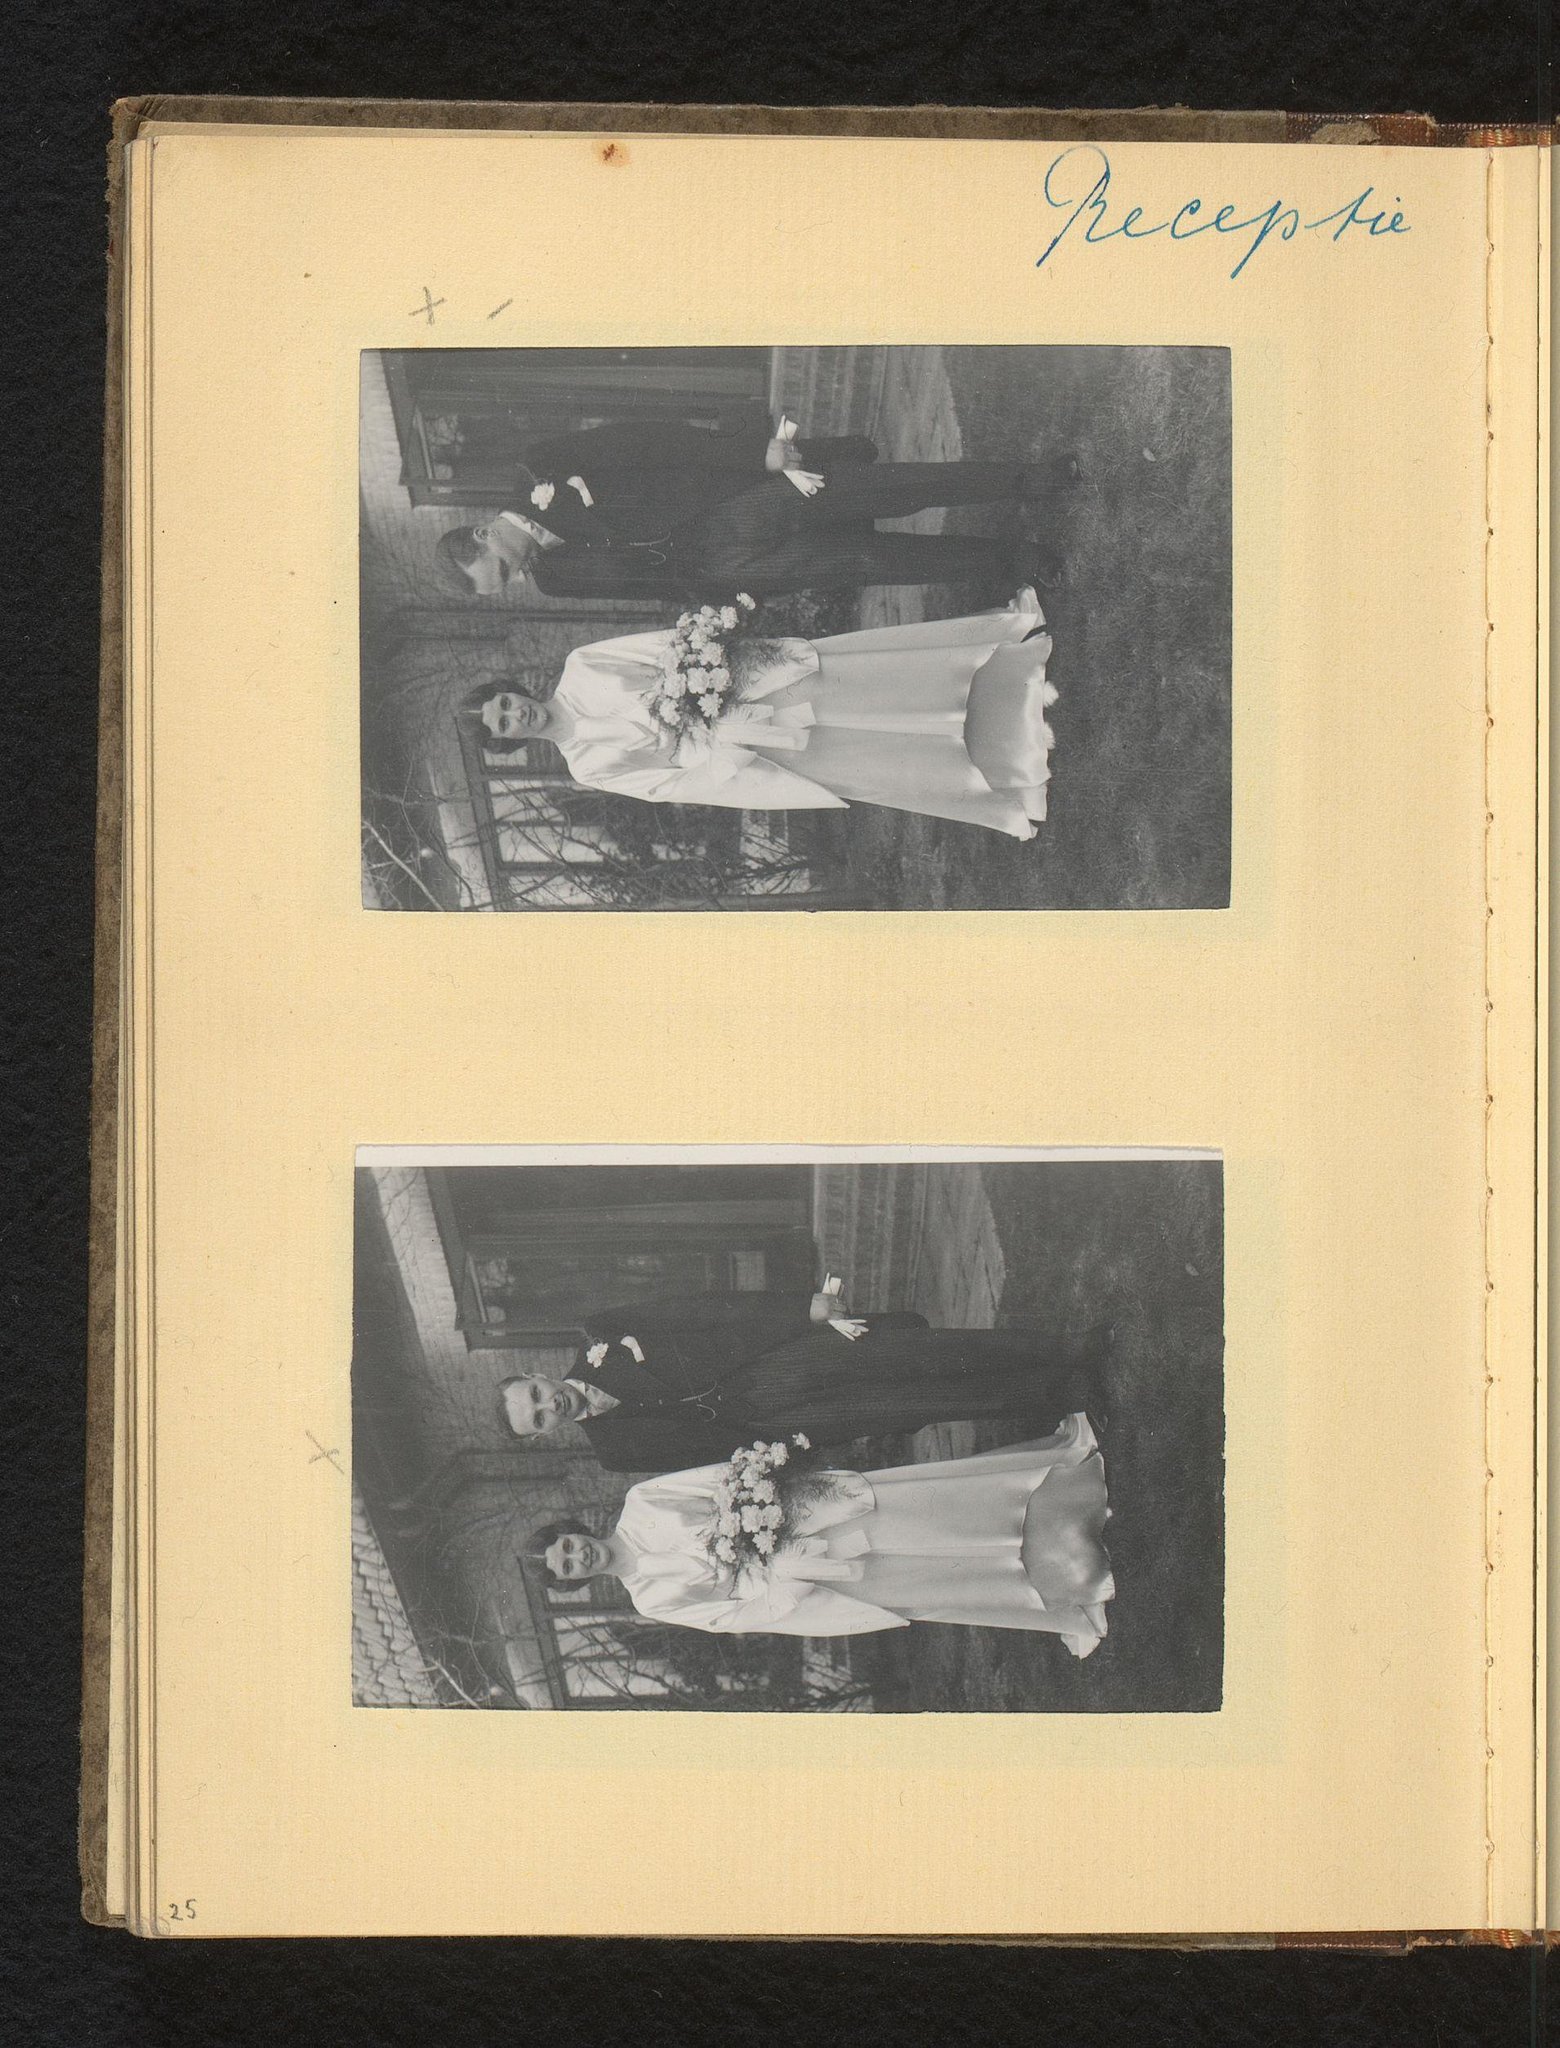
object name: album leaf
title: Twee huwelijksportretten van Jan Hudig en Carla Heeris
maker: Anonymous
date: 1936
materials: paper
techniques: gelatin silver print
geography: the hague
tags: amsterdam, bride and groom in wedding-dress, the hague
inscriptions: inscription: ‘Receptie Blauwe Kamerlaan 2/ 21 Maart 1936’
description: Deze foto's maken deel uit van een album.